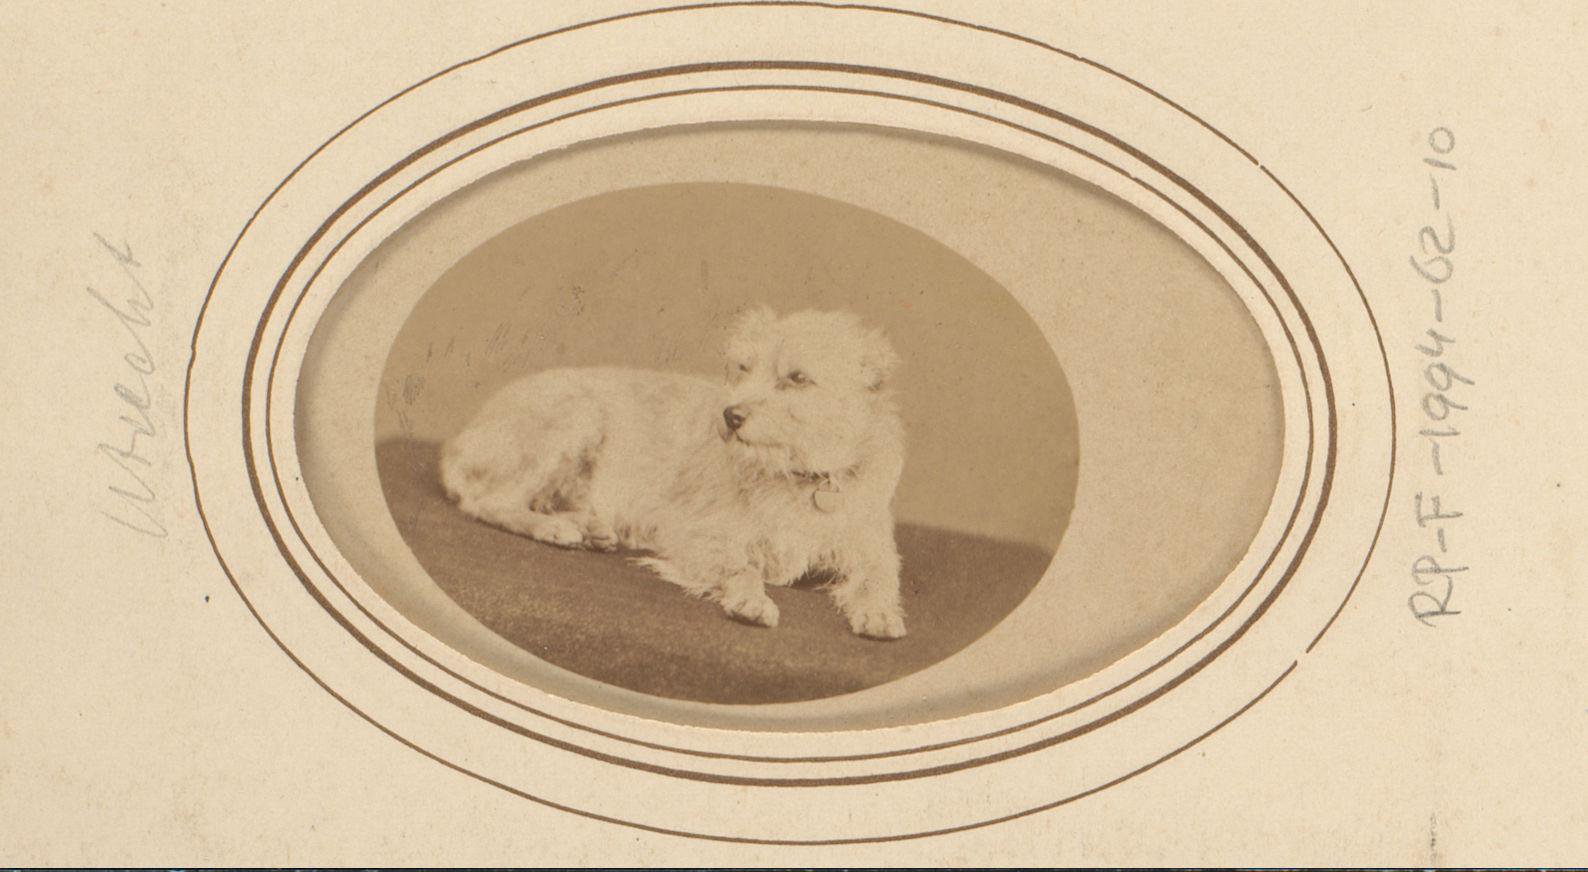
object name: album leaf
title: Portret van een hond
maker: george lodewijk mulder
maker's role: fotograaf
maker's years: 1841-1920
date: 1860-1880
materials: cardboard, photographic support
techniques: albumen print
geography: utrecht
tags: dog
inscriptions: inscription: ‘G.L. Mulder / Utrecht’, inscription: ‘Photogr. Atelier / G.L. Mulder / van Wijckskade H. 326 / Utrecht’